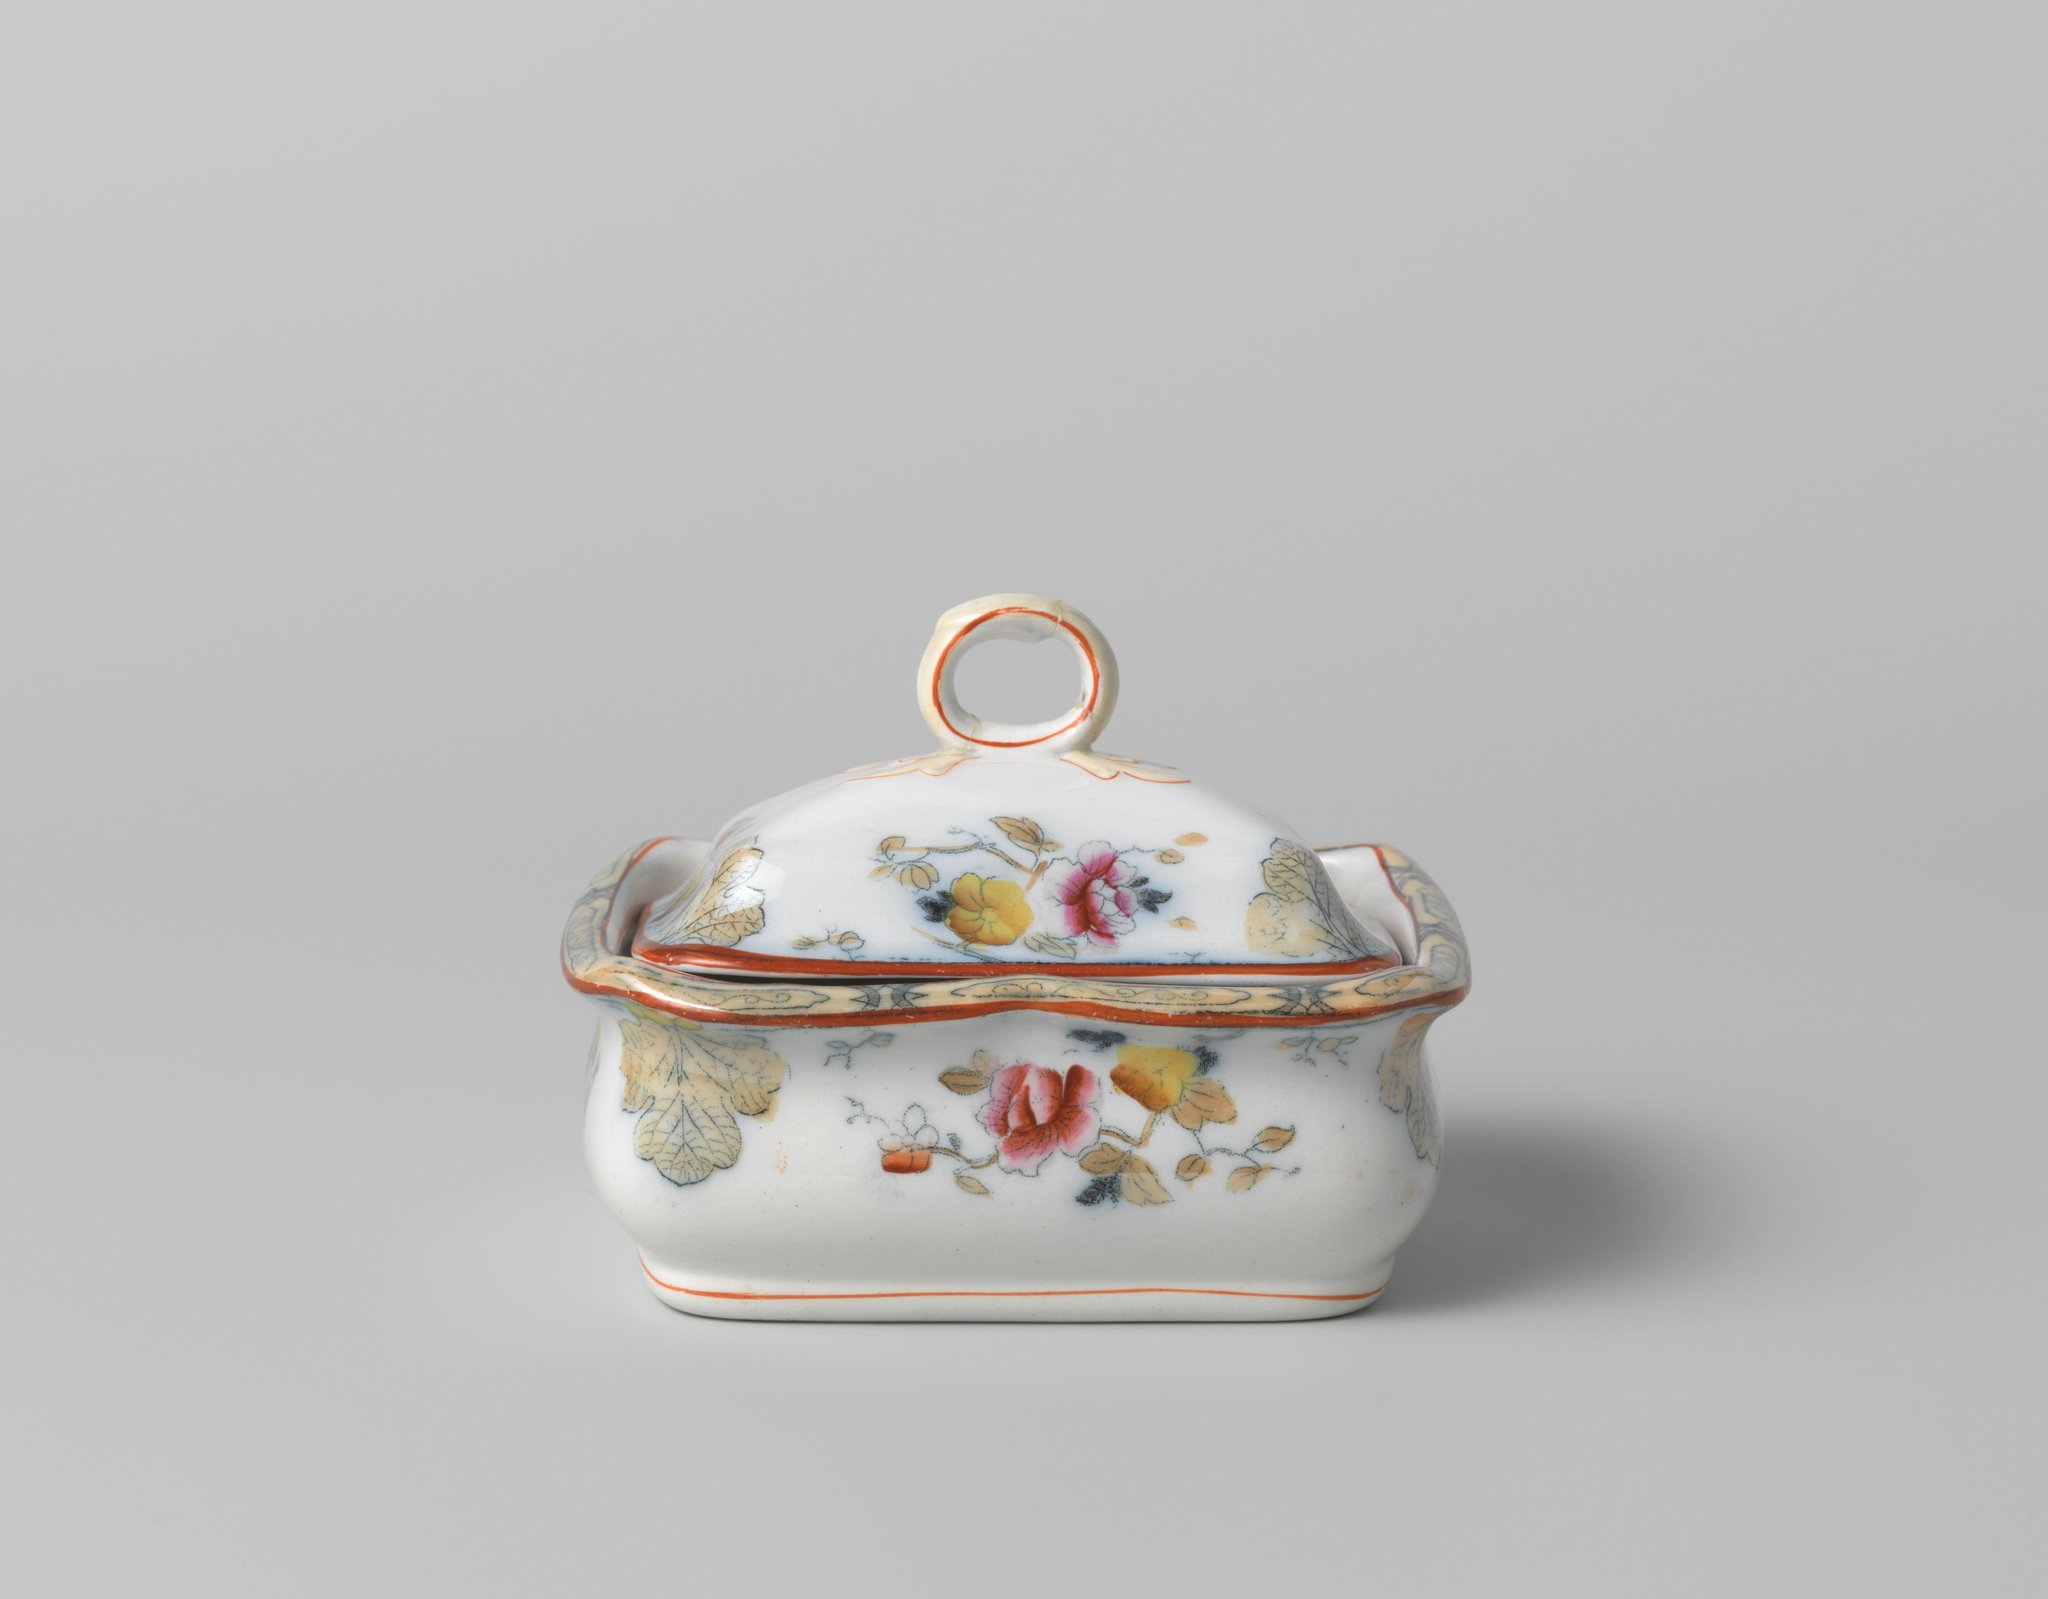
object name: box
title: Zeepdoos met veelkleurige bloemen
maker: petrus regout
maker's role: plateelbakker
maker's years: 1801-1879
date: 1882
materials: earthenware, glaze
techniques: vitrification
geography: maastricht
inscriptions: check stamp: ‘F AC’, check stamp: ‘F .. (?)’, mark: ‘sfinx // P. REGOUT & Co // MAASTRICHT // VESTA’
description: Zeepdoos van aardewerk met blauwzwart transferdecor, beschilderd met moffelkleuren en okerluster. De rechthoekige bak heeft afgeronde hoeken en een gewelfde wand. De wand met veelkleurige bloemen en bladeren. De uitstekende bovenrand van de wand is gedecoreerd met een abstract blauwzwart motief onder okerluster. Het rechthoekige, gewelfde heeft langs de rand een band van veelkleurige bloemen en bladeren.